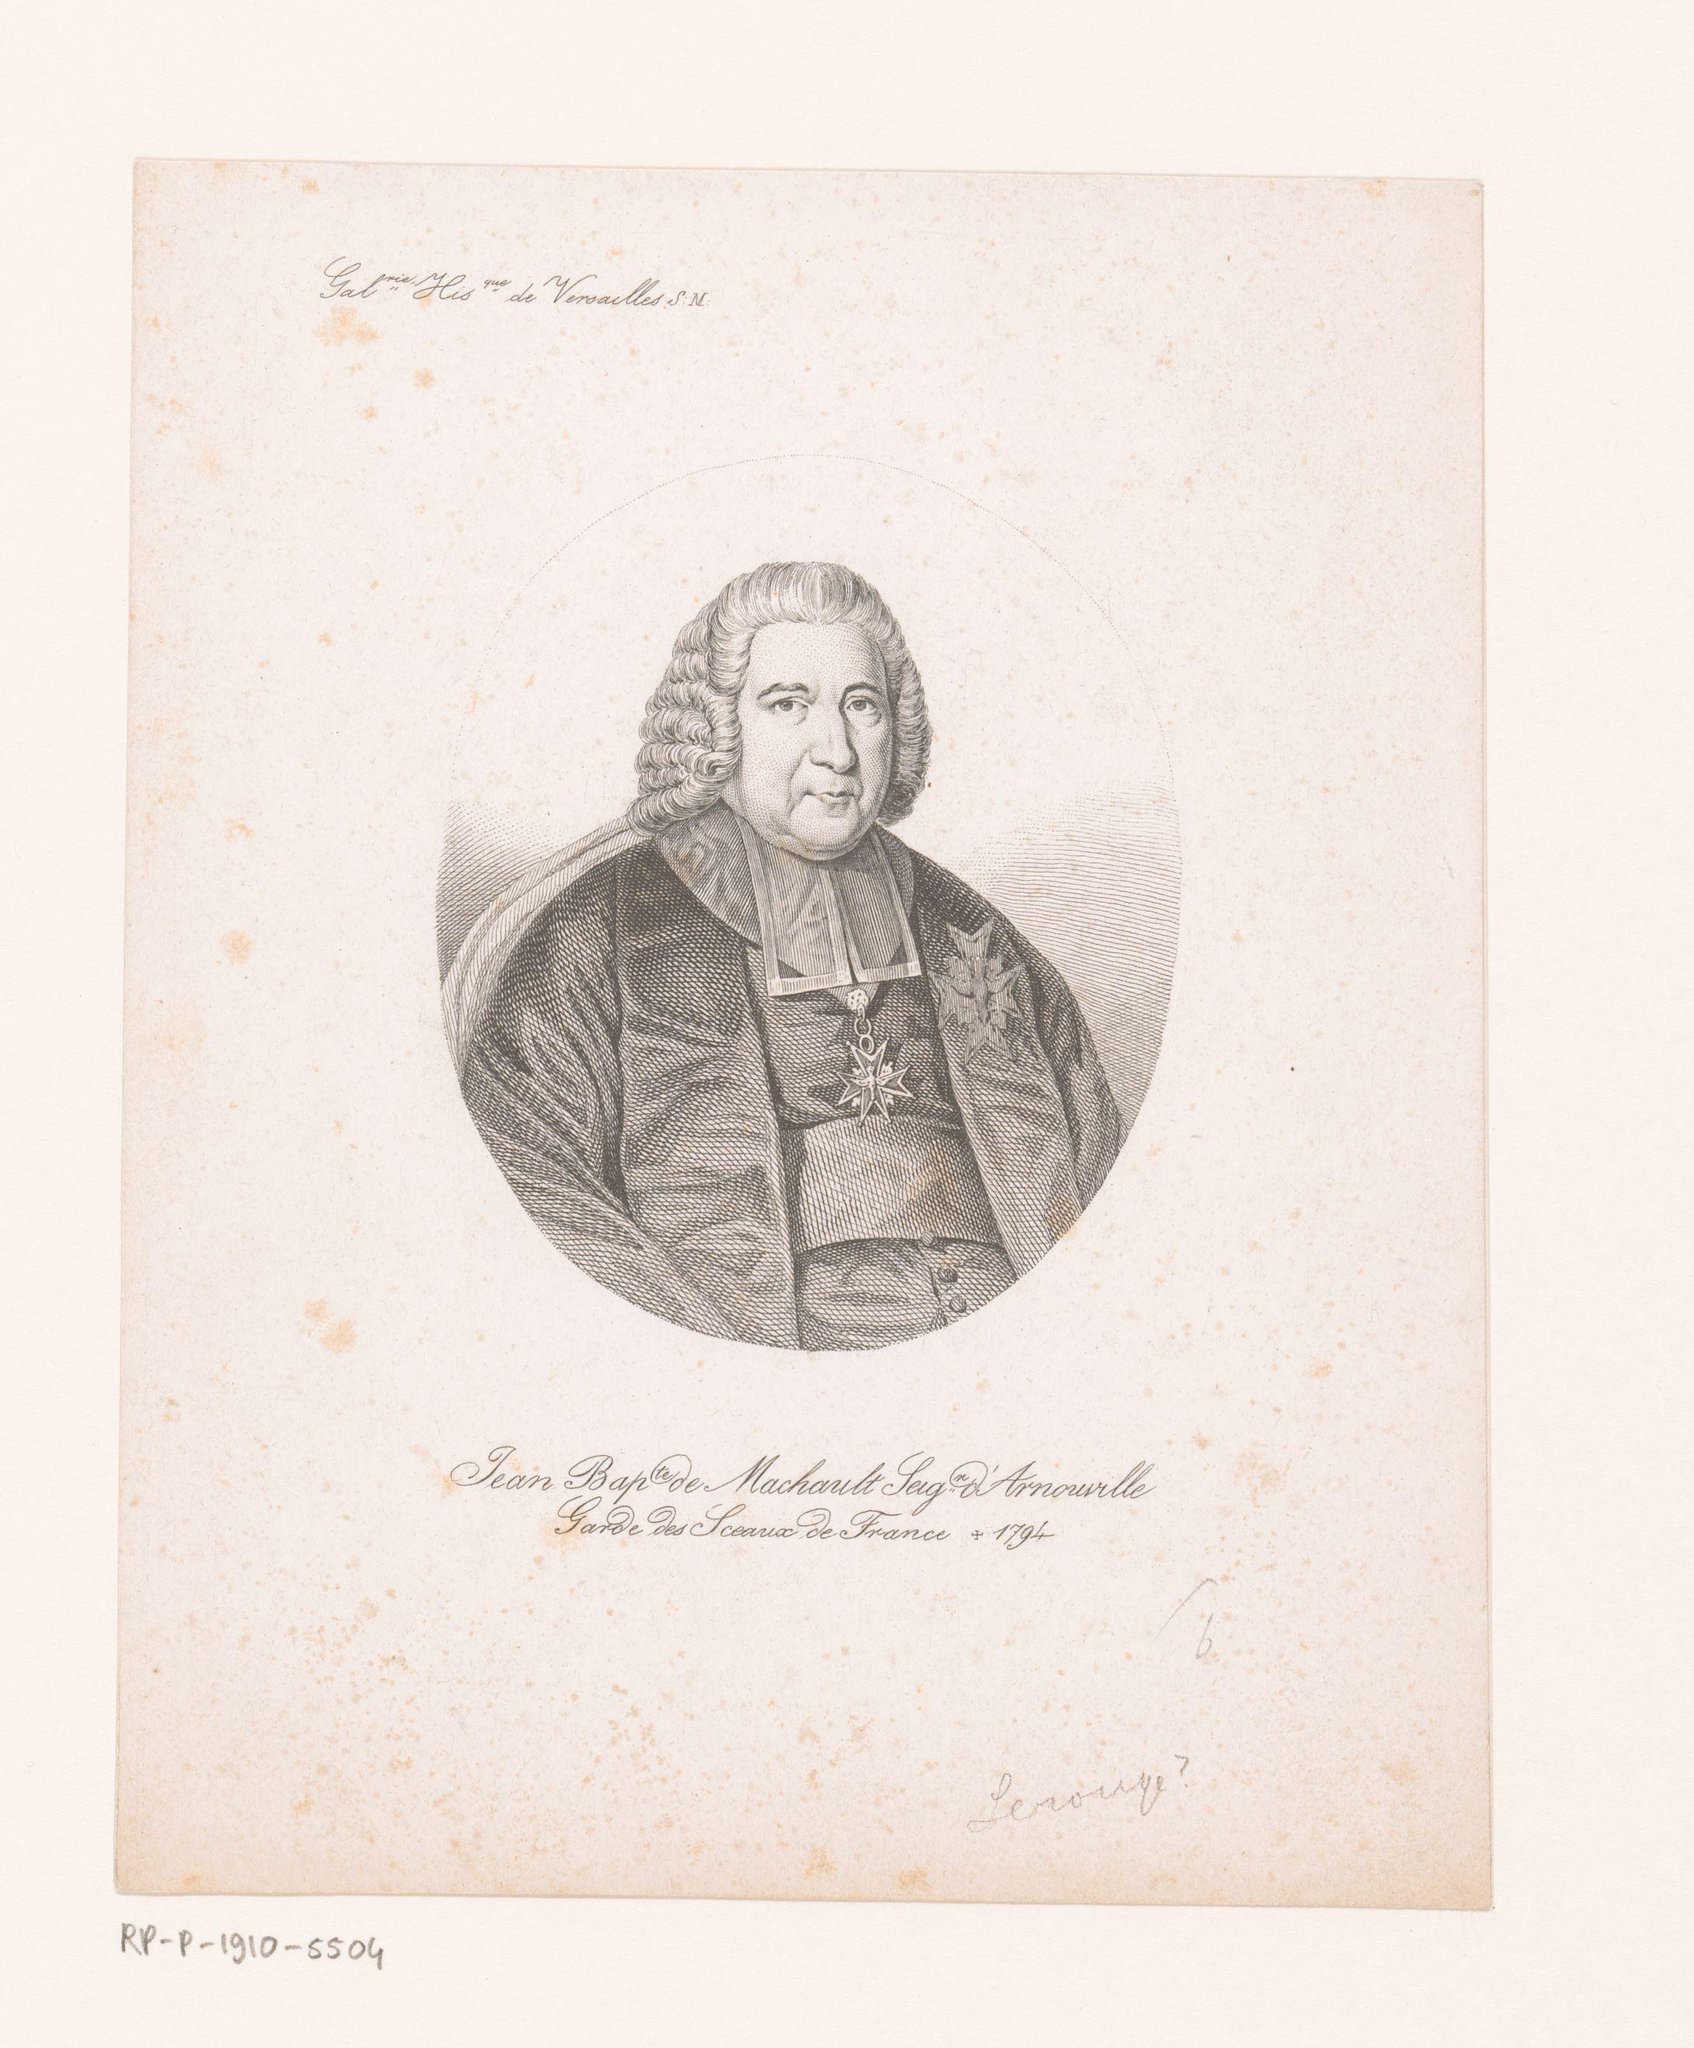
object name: print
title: Portret van Jean-Baptiste de Machault d'Arnouville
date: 1838-1841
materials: paper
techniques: etching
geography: paris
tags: politician, jean-baptiste de machault d'arnouville, historical persons, politician, e.g. party leader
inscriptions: collector's mark: Lugt 2228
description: Prent uit: Galeries historiques de Versailles. Parijs: Charles Gavard, 1838-1841.